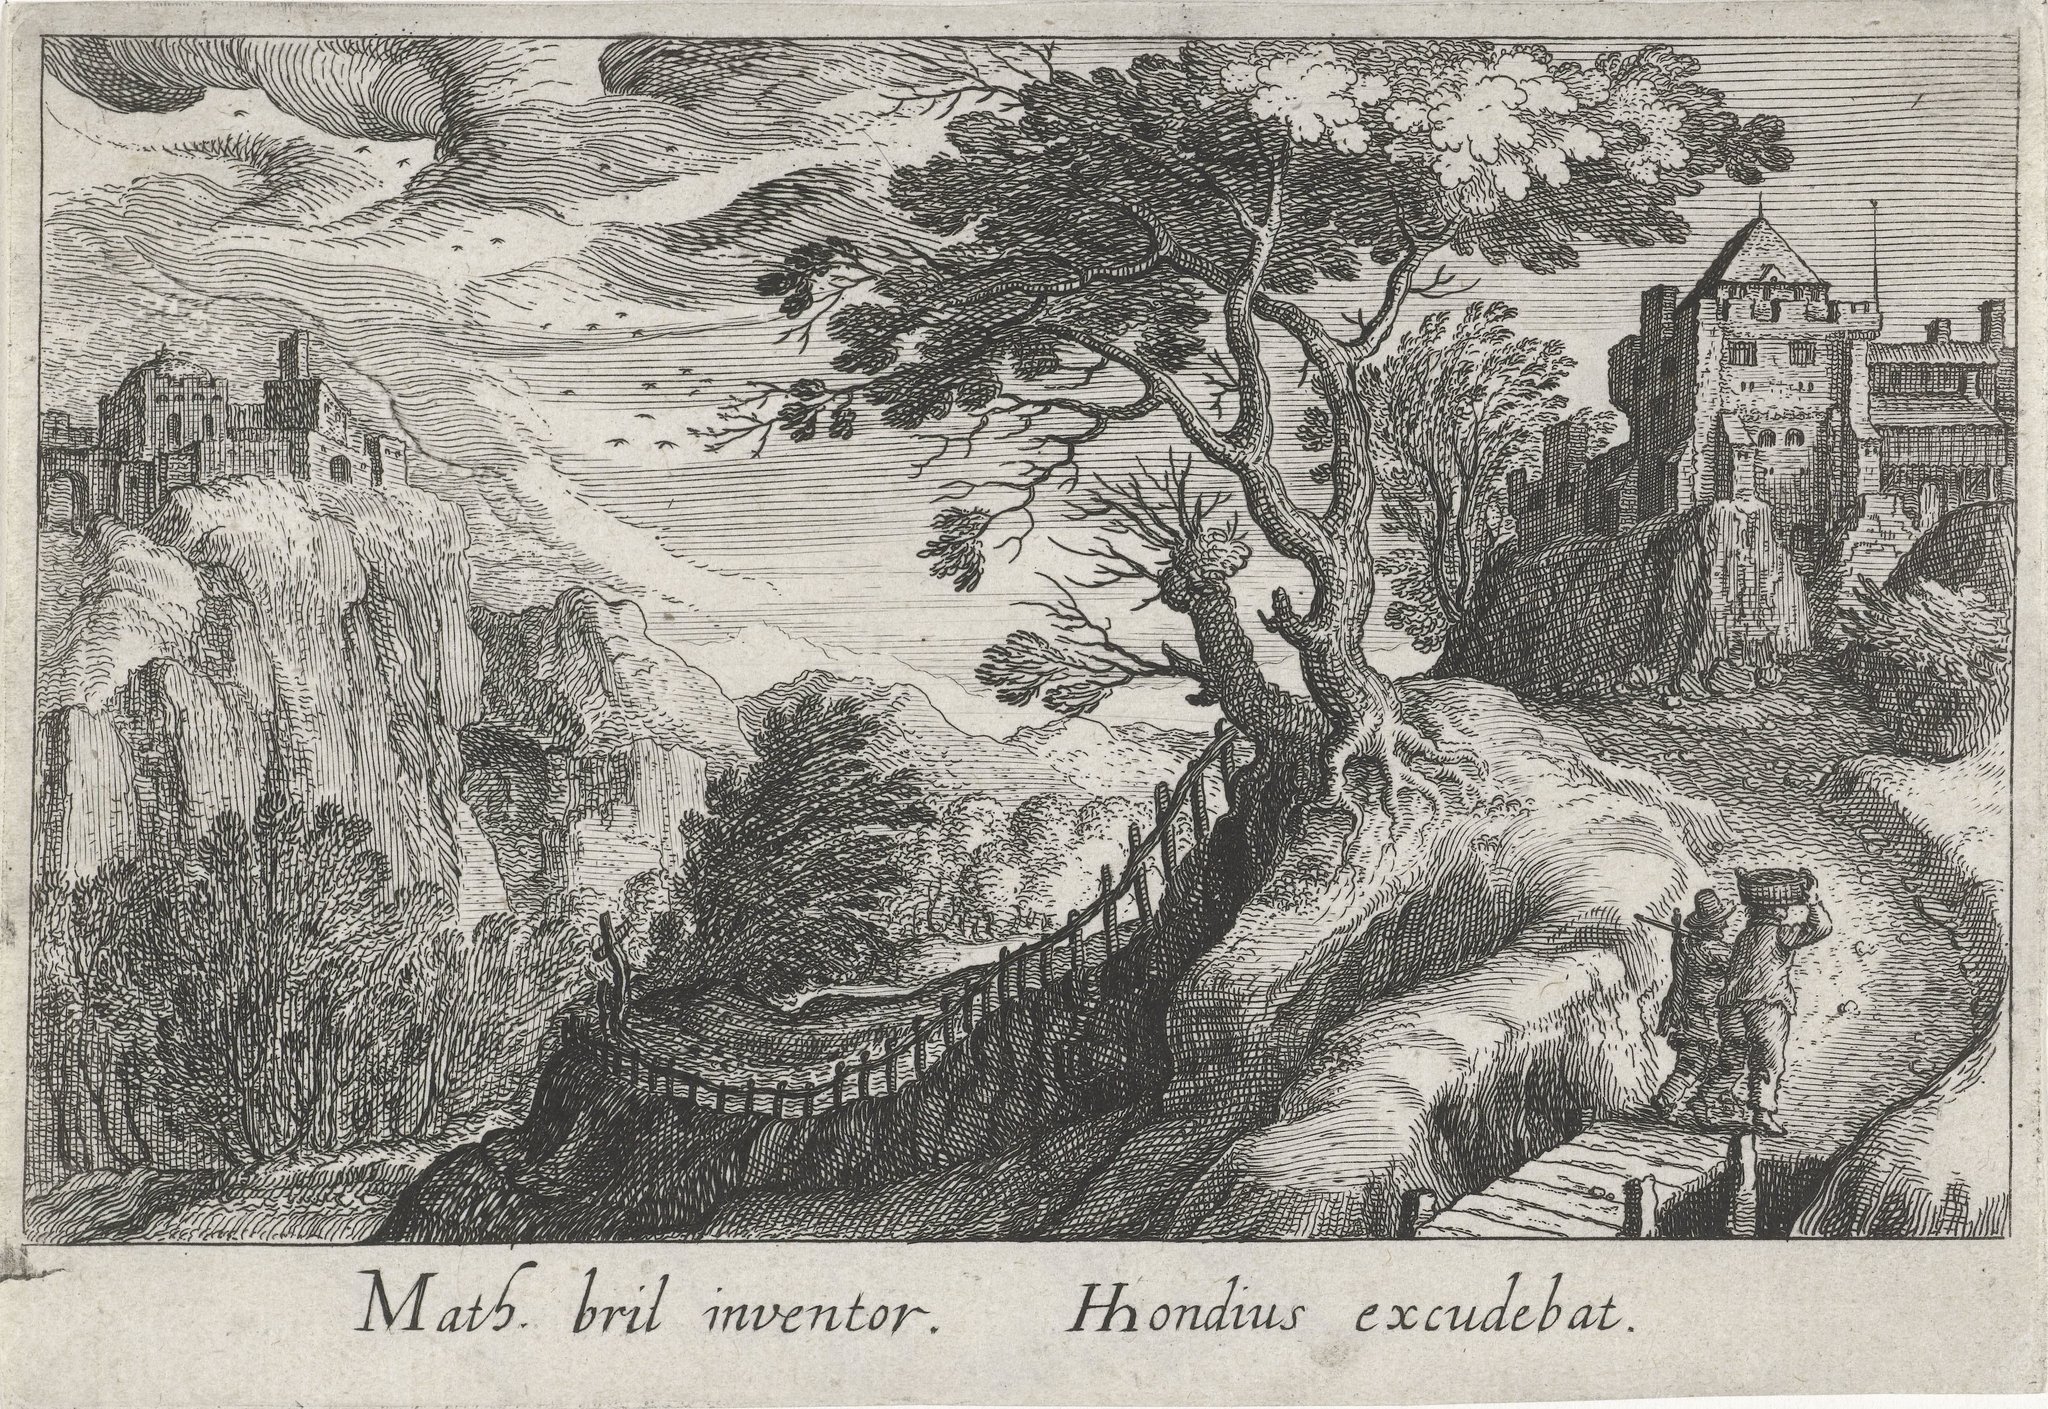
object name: print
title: Topographia variarum regionum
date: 1614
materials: paper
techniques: etching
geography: northern netherlands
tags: landscapes (+ landscape with figures, staffage)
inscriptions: collector's mark: Lugt 2228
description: Rechts op de voorgrond lopen twee figuren over een pad richting een versterkt gebouw op een berg. In de lucht vliegen zwaluwen.